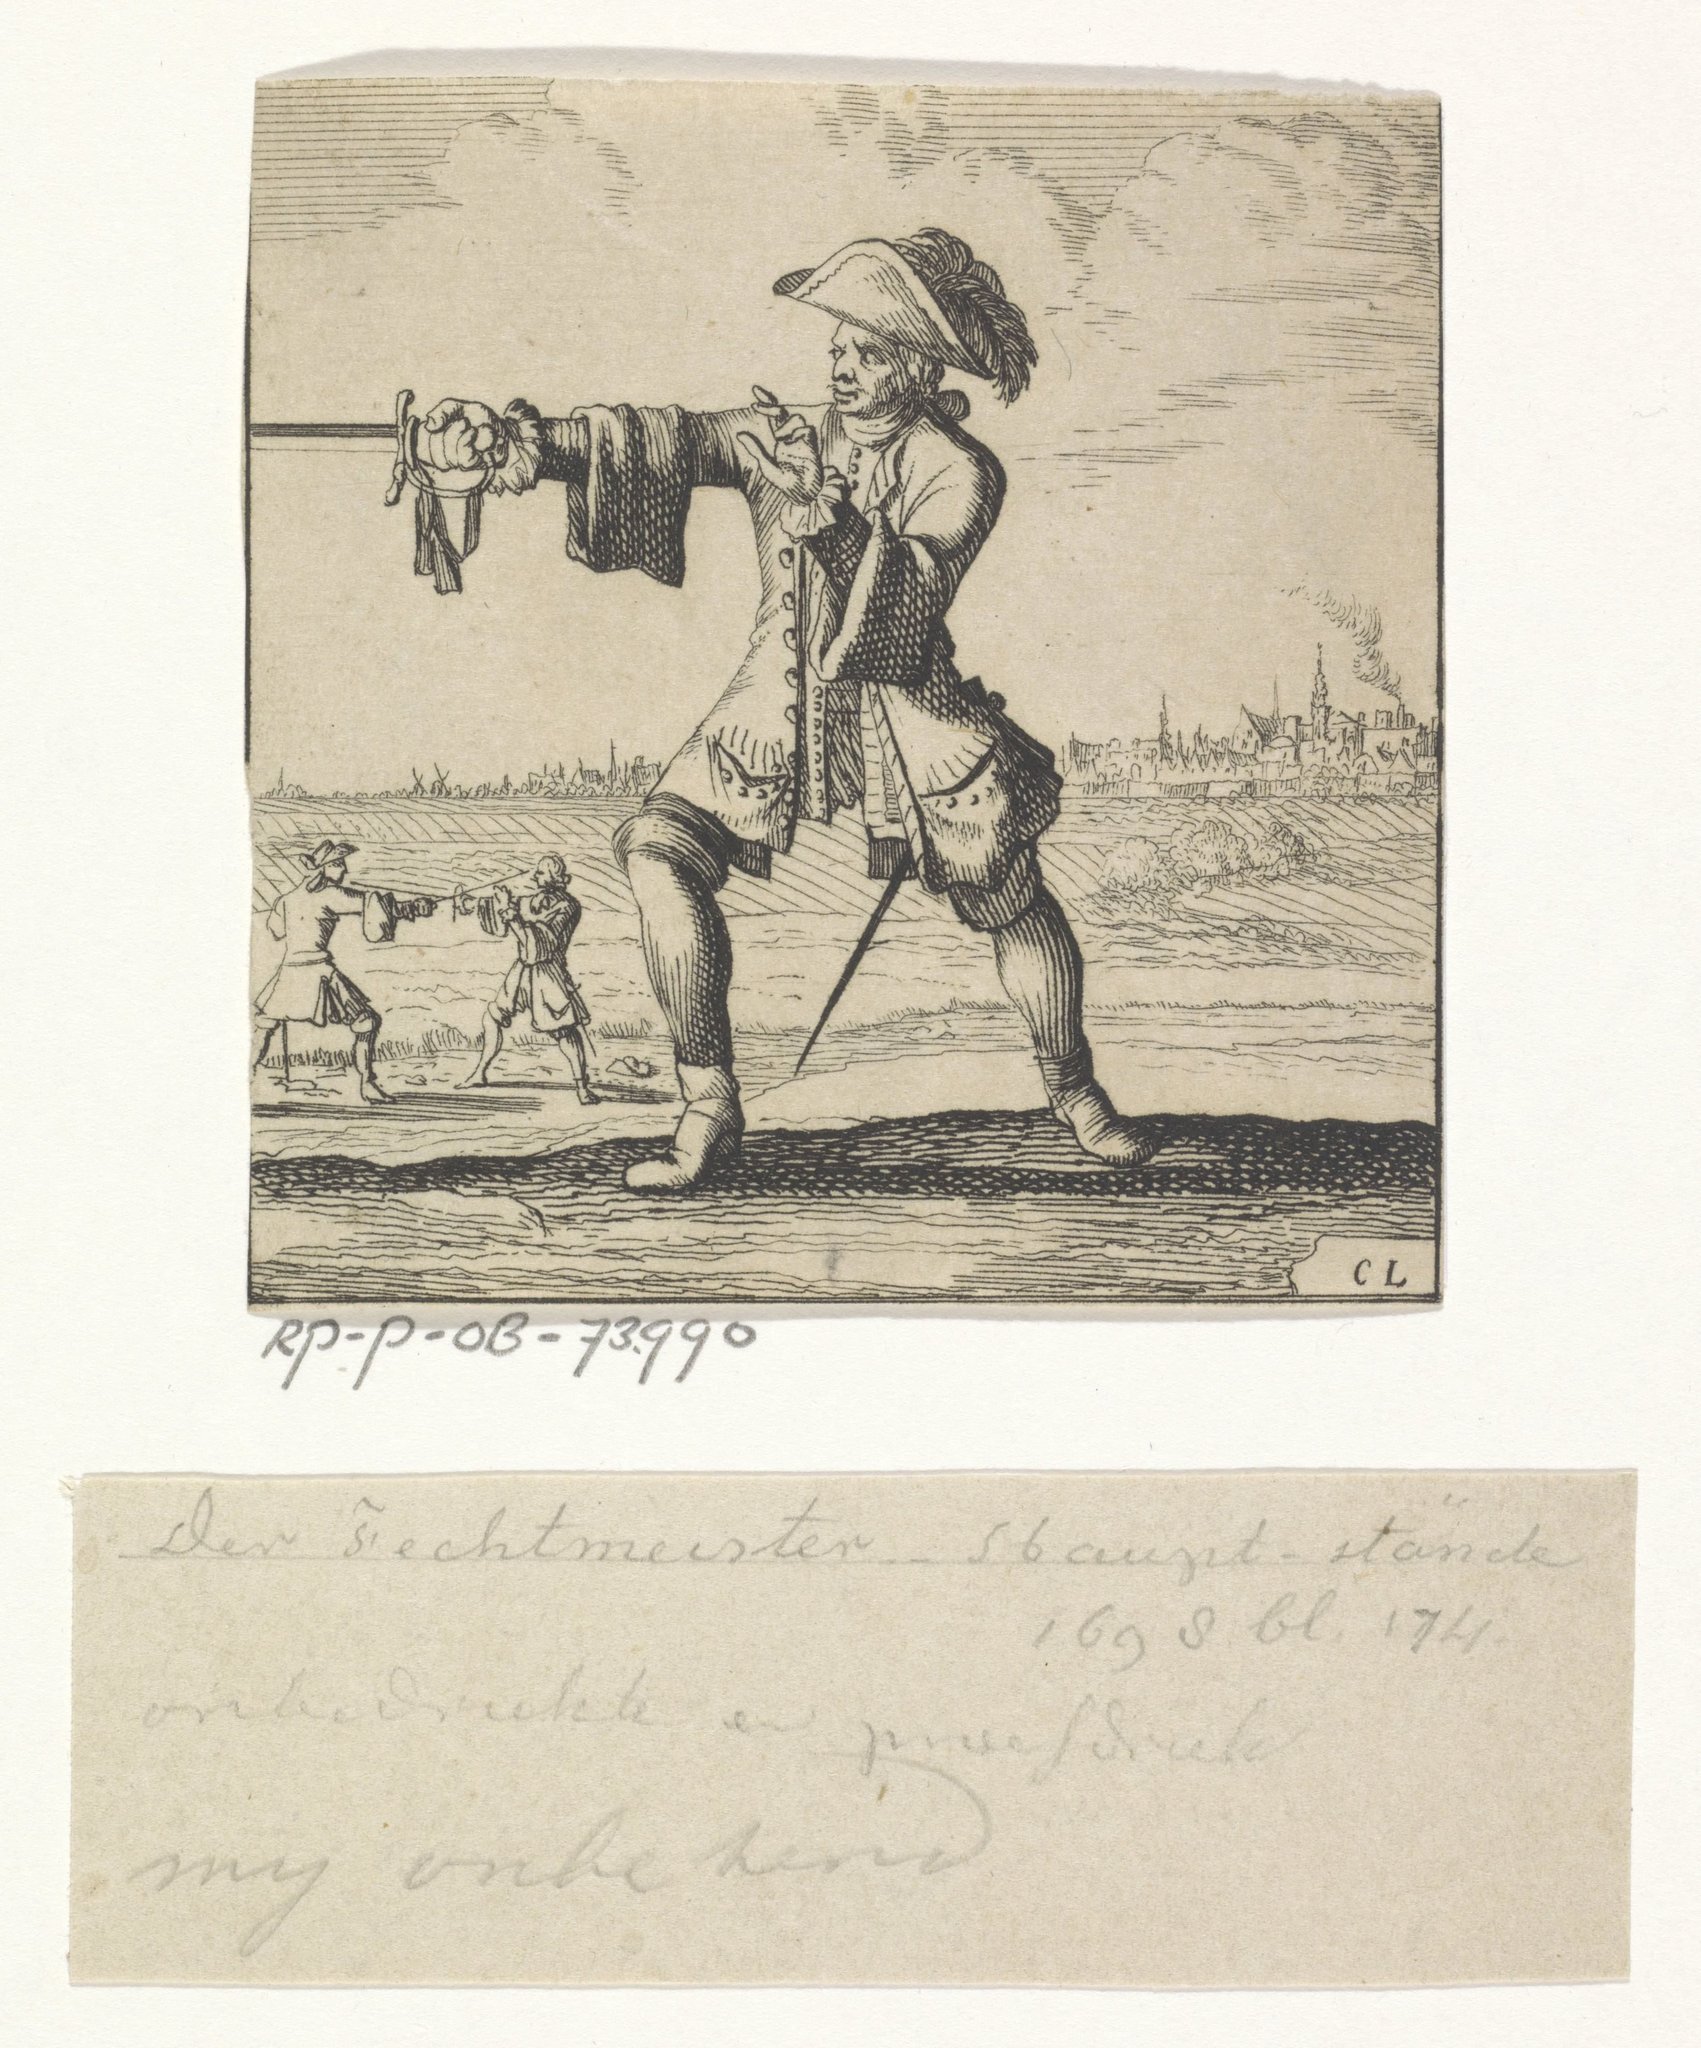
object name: print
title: Wapenoefening met de degen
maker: monogrammist cl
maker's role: print maker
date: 1600-1700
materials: paper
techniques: etching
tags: handling of weapons ~ military training